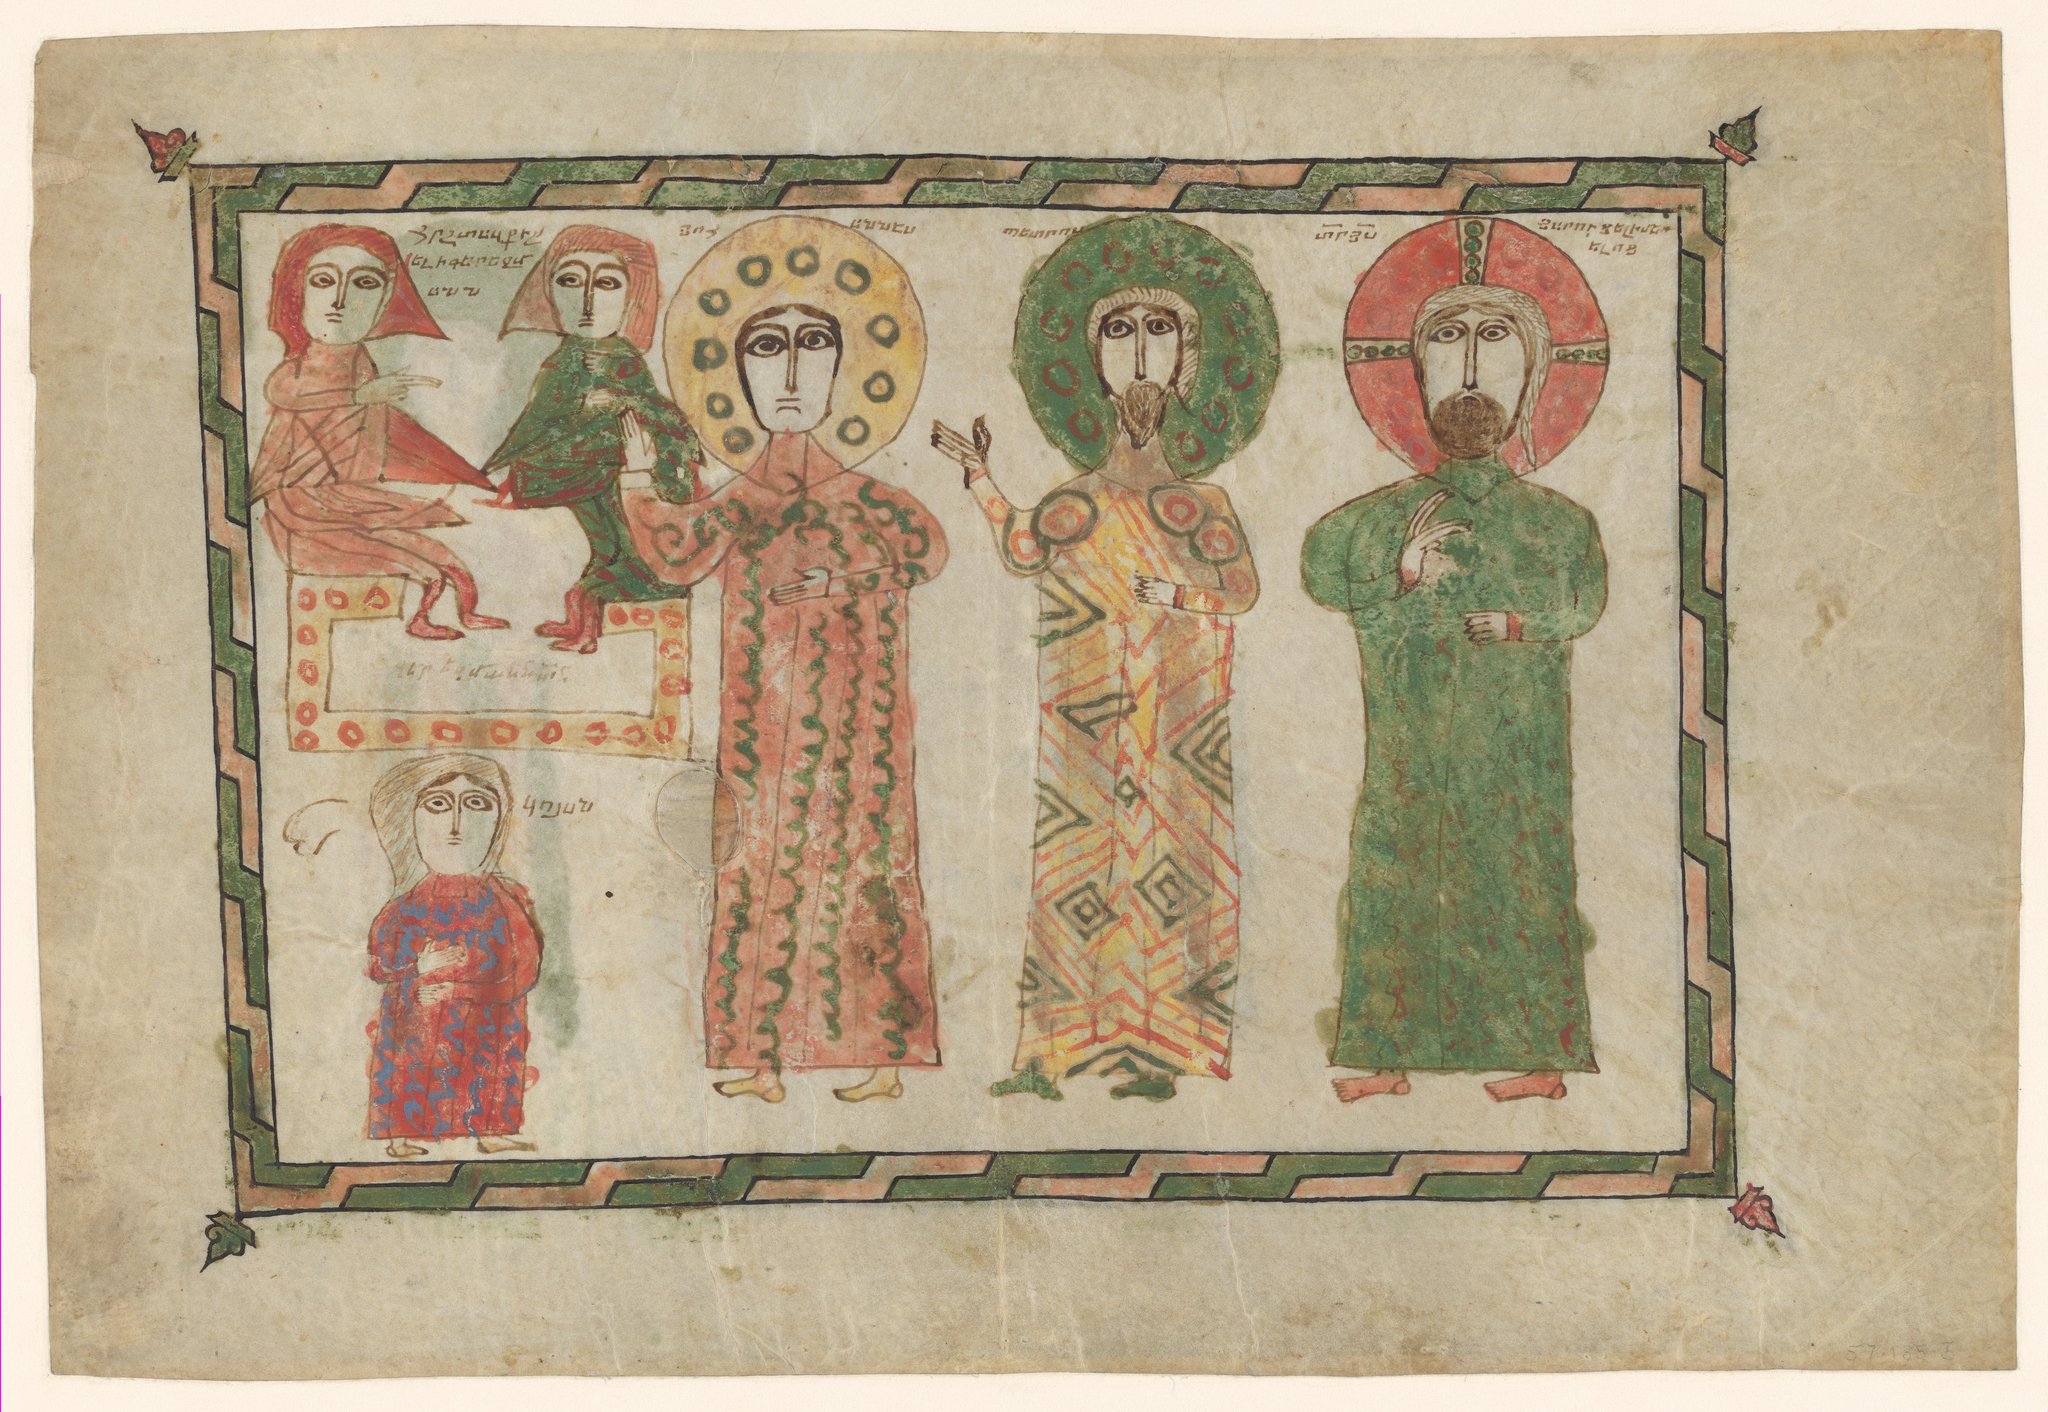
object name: gospel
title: Leaf from a Gospel Book with Four Standing Evangelists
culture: armenian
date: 1290-1330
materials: ink, parchment, paint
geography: lake van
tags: men,saint mark,saint matthew,evangelists,saint luke,saint john